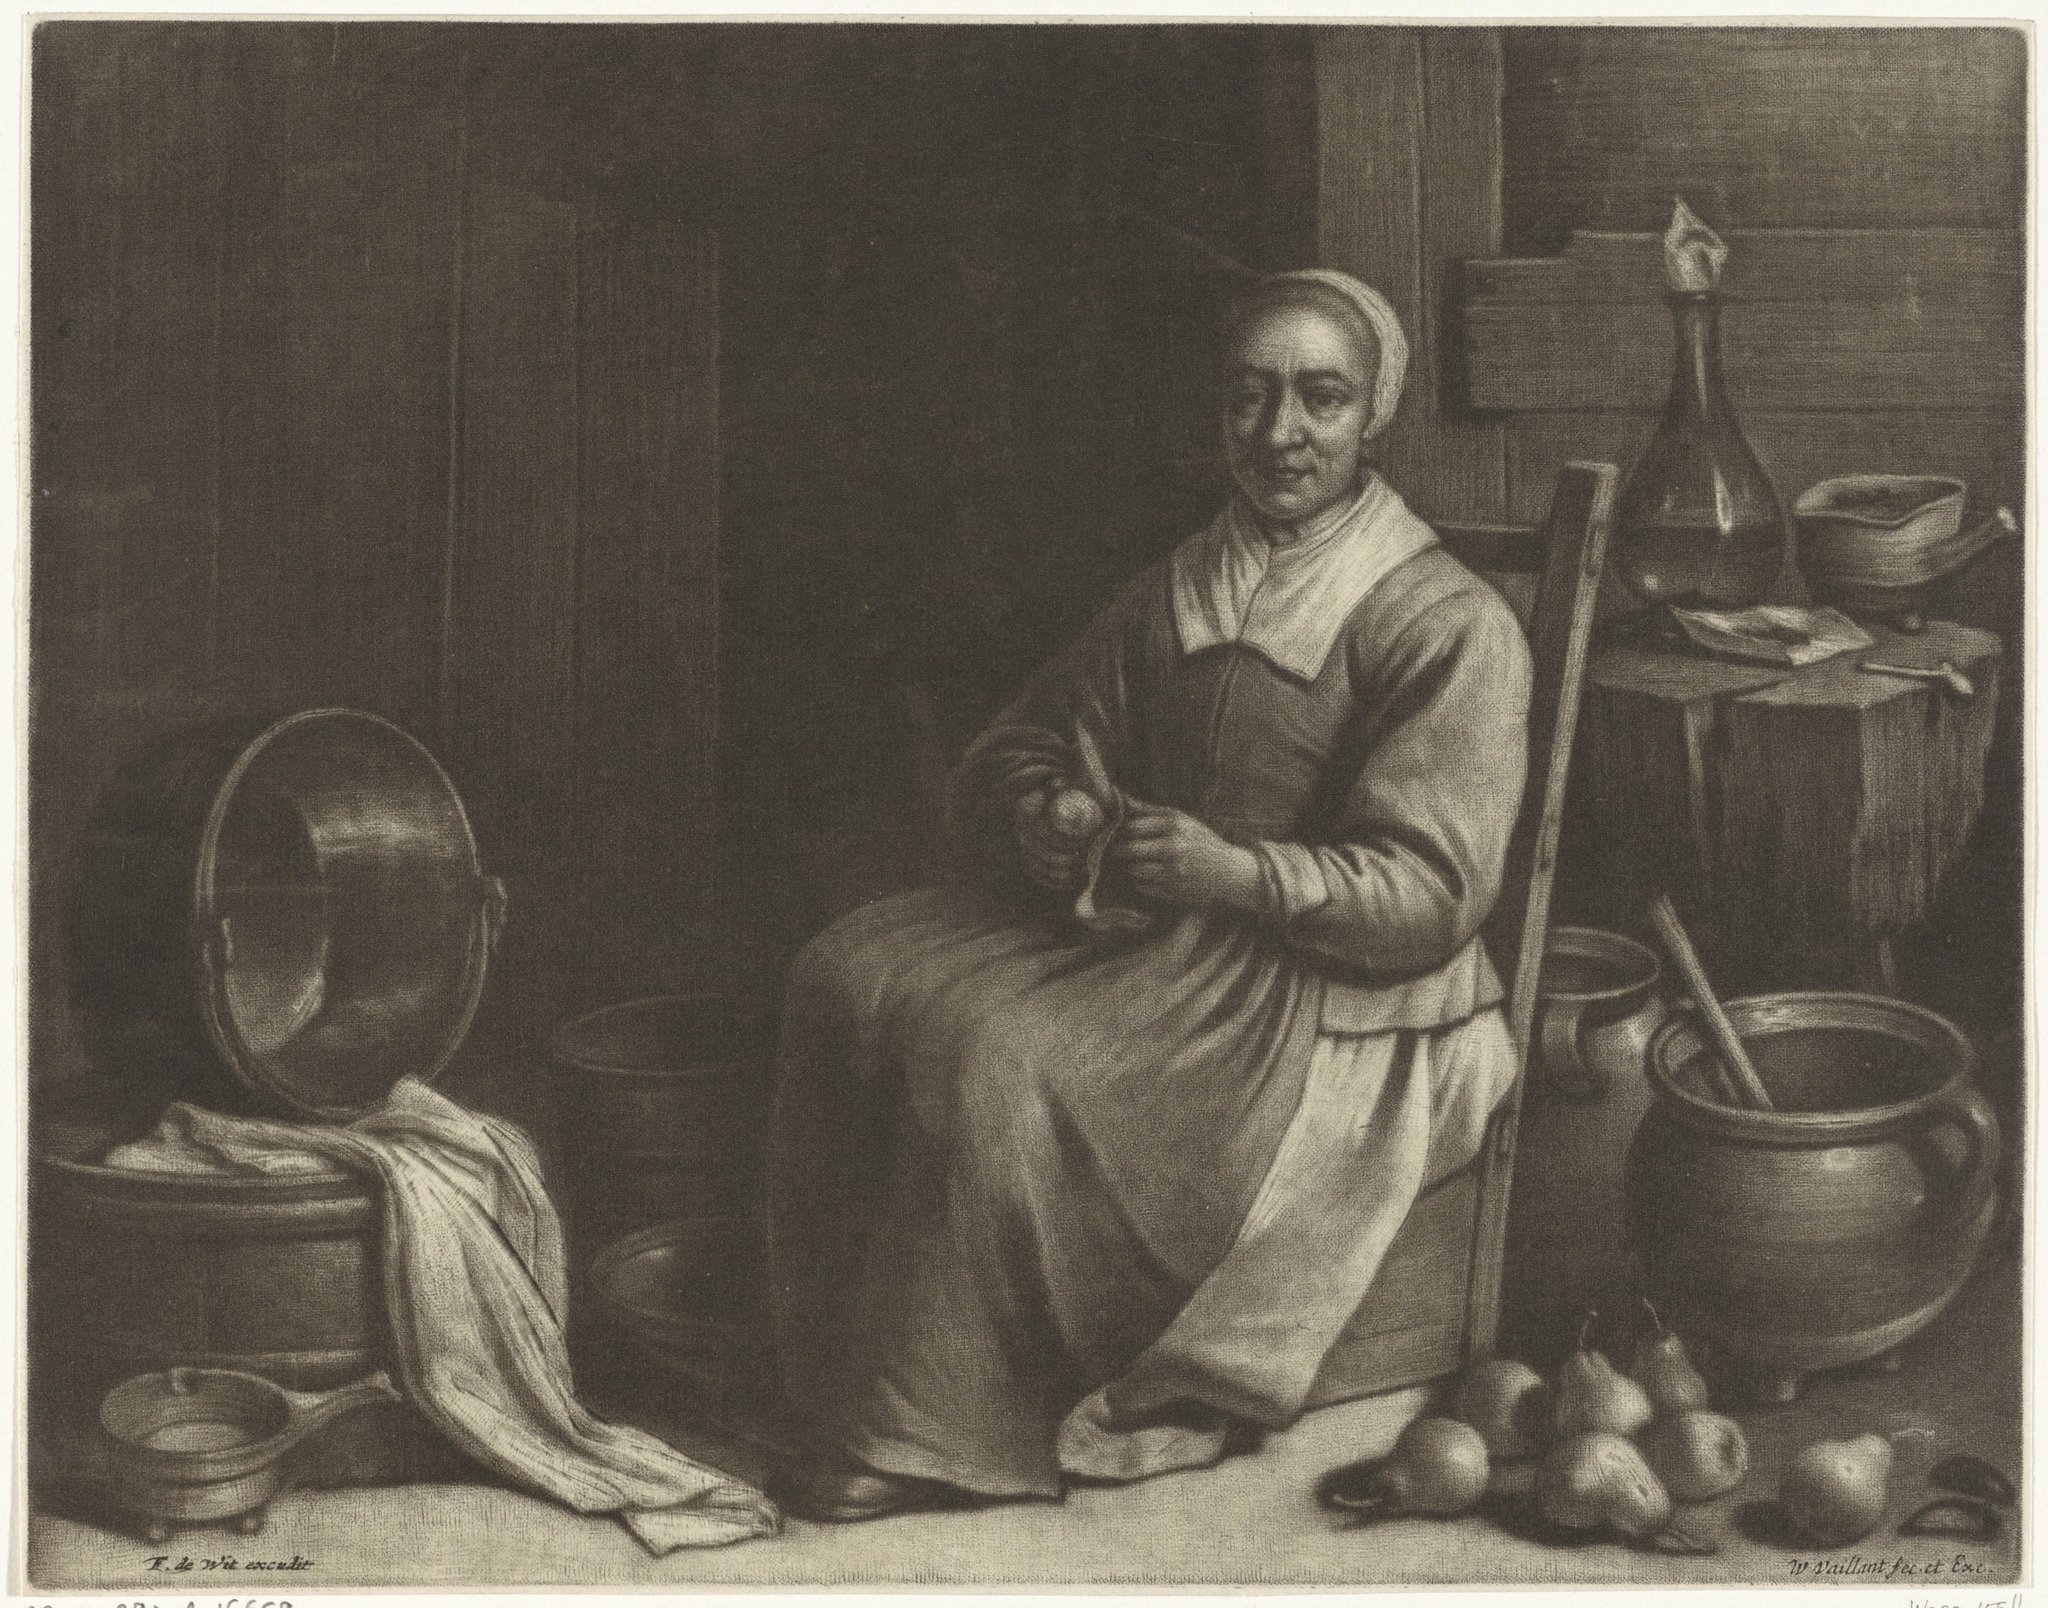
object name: print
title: Vrouw die peren schilt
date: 1658-1706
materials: paper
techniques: mezzotint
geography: amsterdam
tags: fruits: pear, kitchen-interior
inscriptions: collector's mark: Lugt 2228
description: In een keuken zit een vrouw tussen de kookpotten peren te schillen.